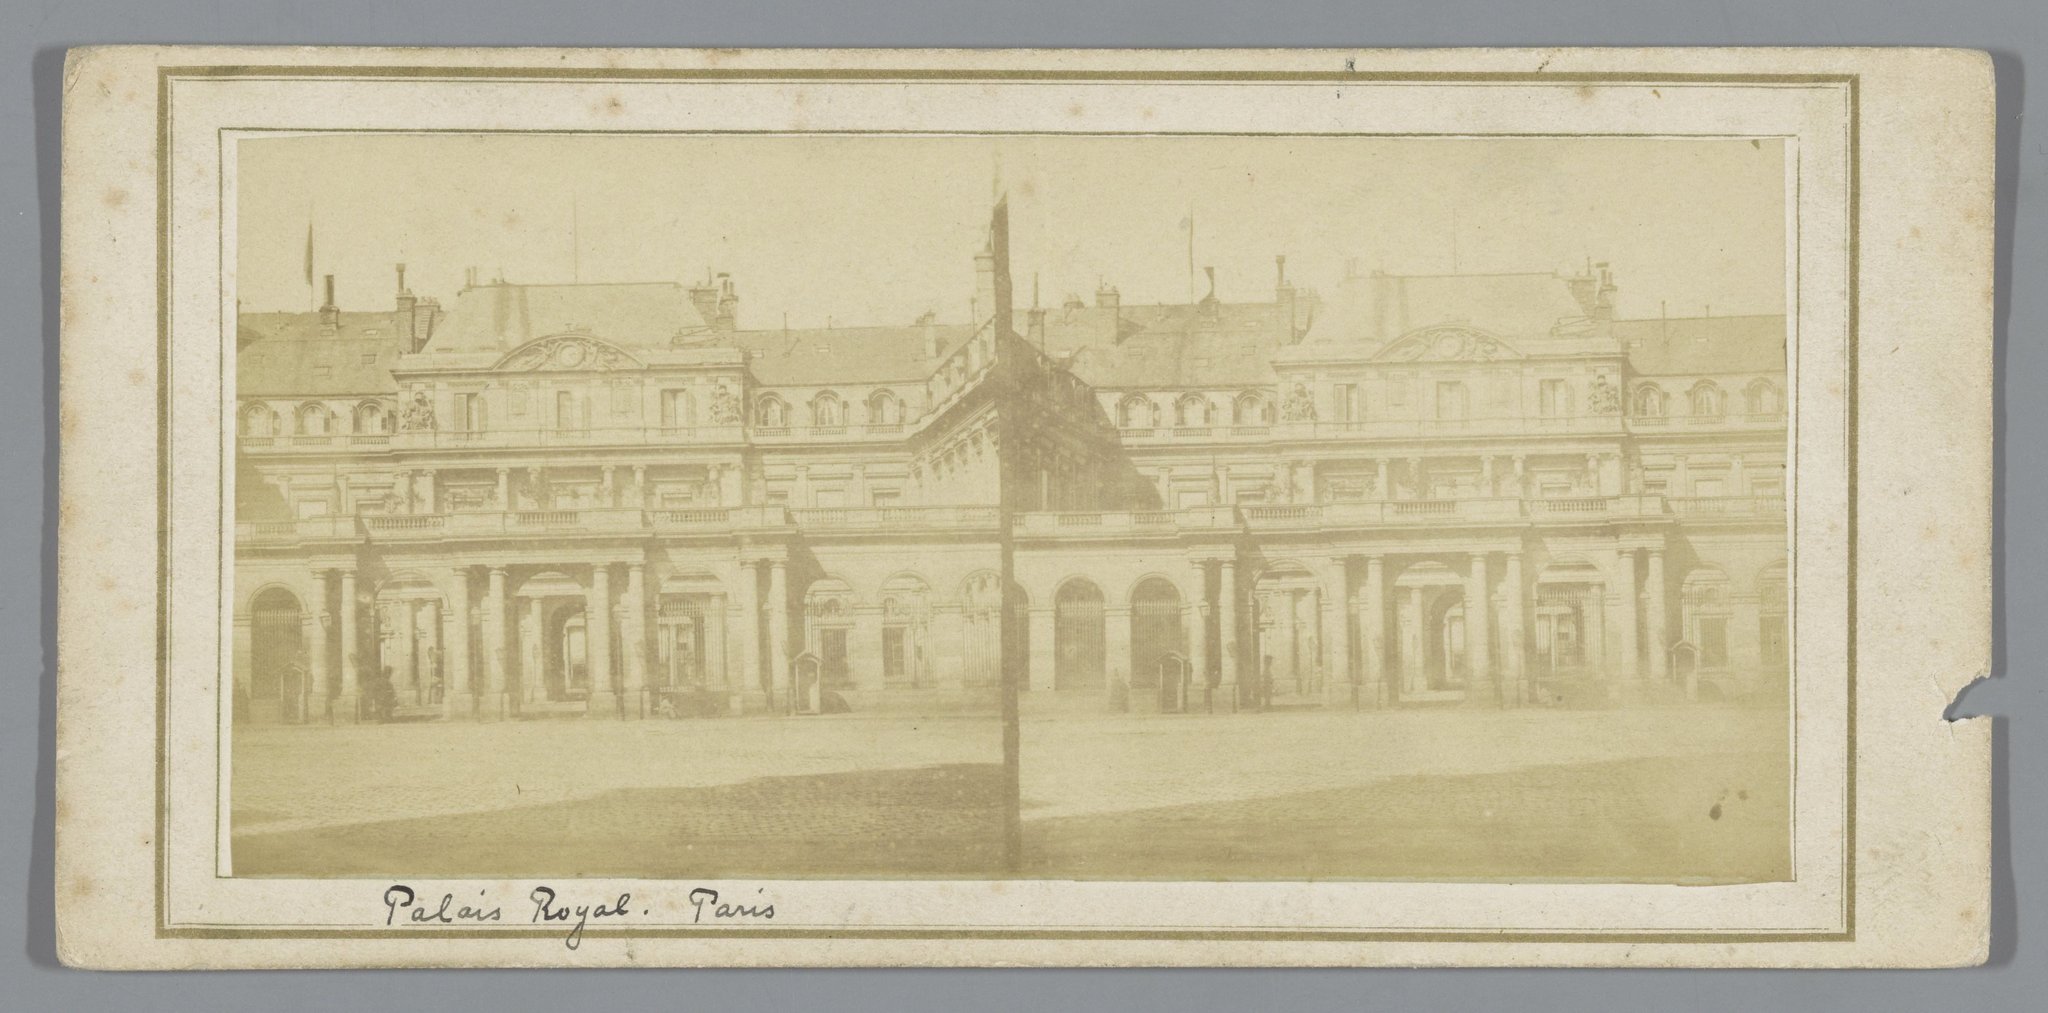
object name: stereograph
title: Palais-Royal, Parijs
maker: Anonymous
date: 1857-1863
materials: cardboard, paper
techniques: albumen print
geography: paris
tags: palace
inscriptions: inscription: ‘D. 79’, title: ‘Palais Royal’, number: ‘109’